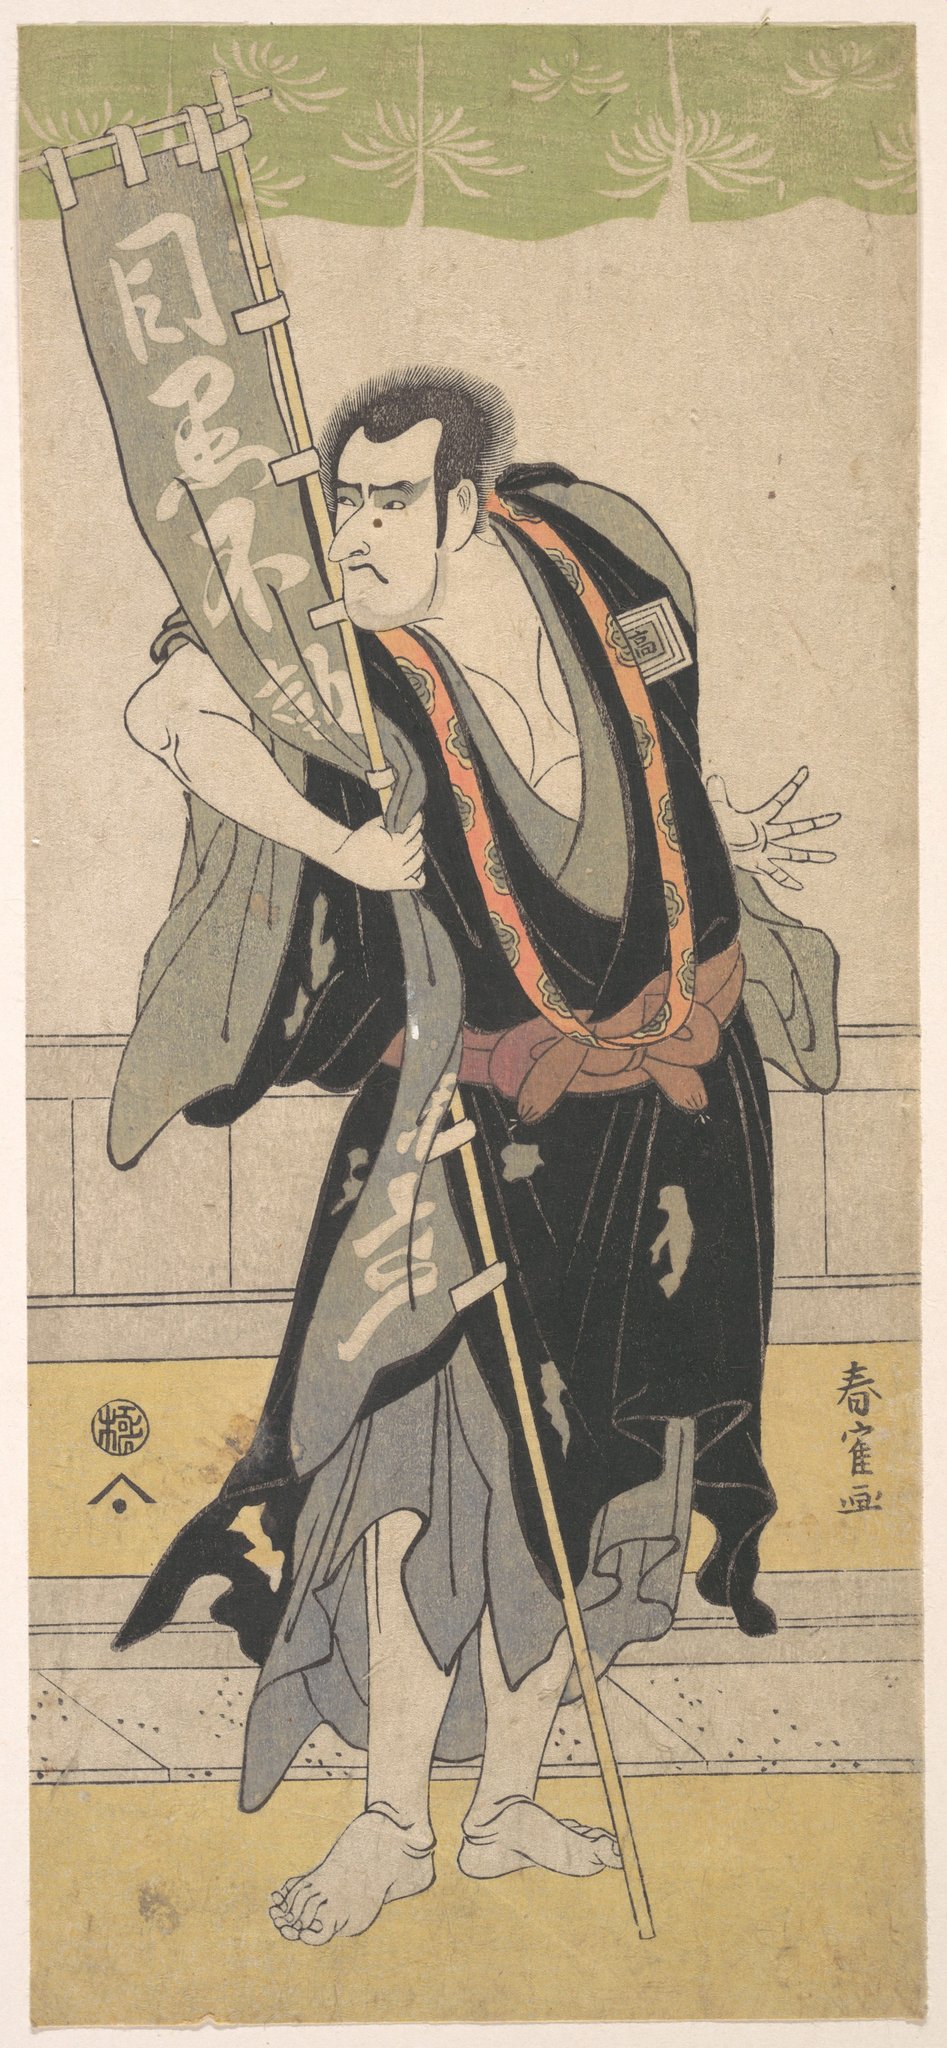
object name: print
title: The 2nd Ichikawa Komazo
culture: japanese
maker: katsukawa shunkaku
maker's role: artist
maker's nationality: japanese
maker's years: 1789-1801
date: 1795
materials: ink, paper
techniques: woodblock print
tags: men